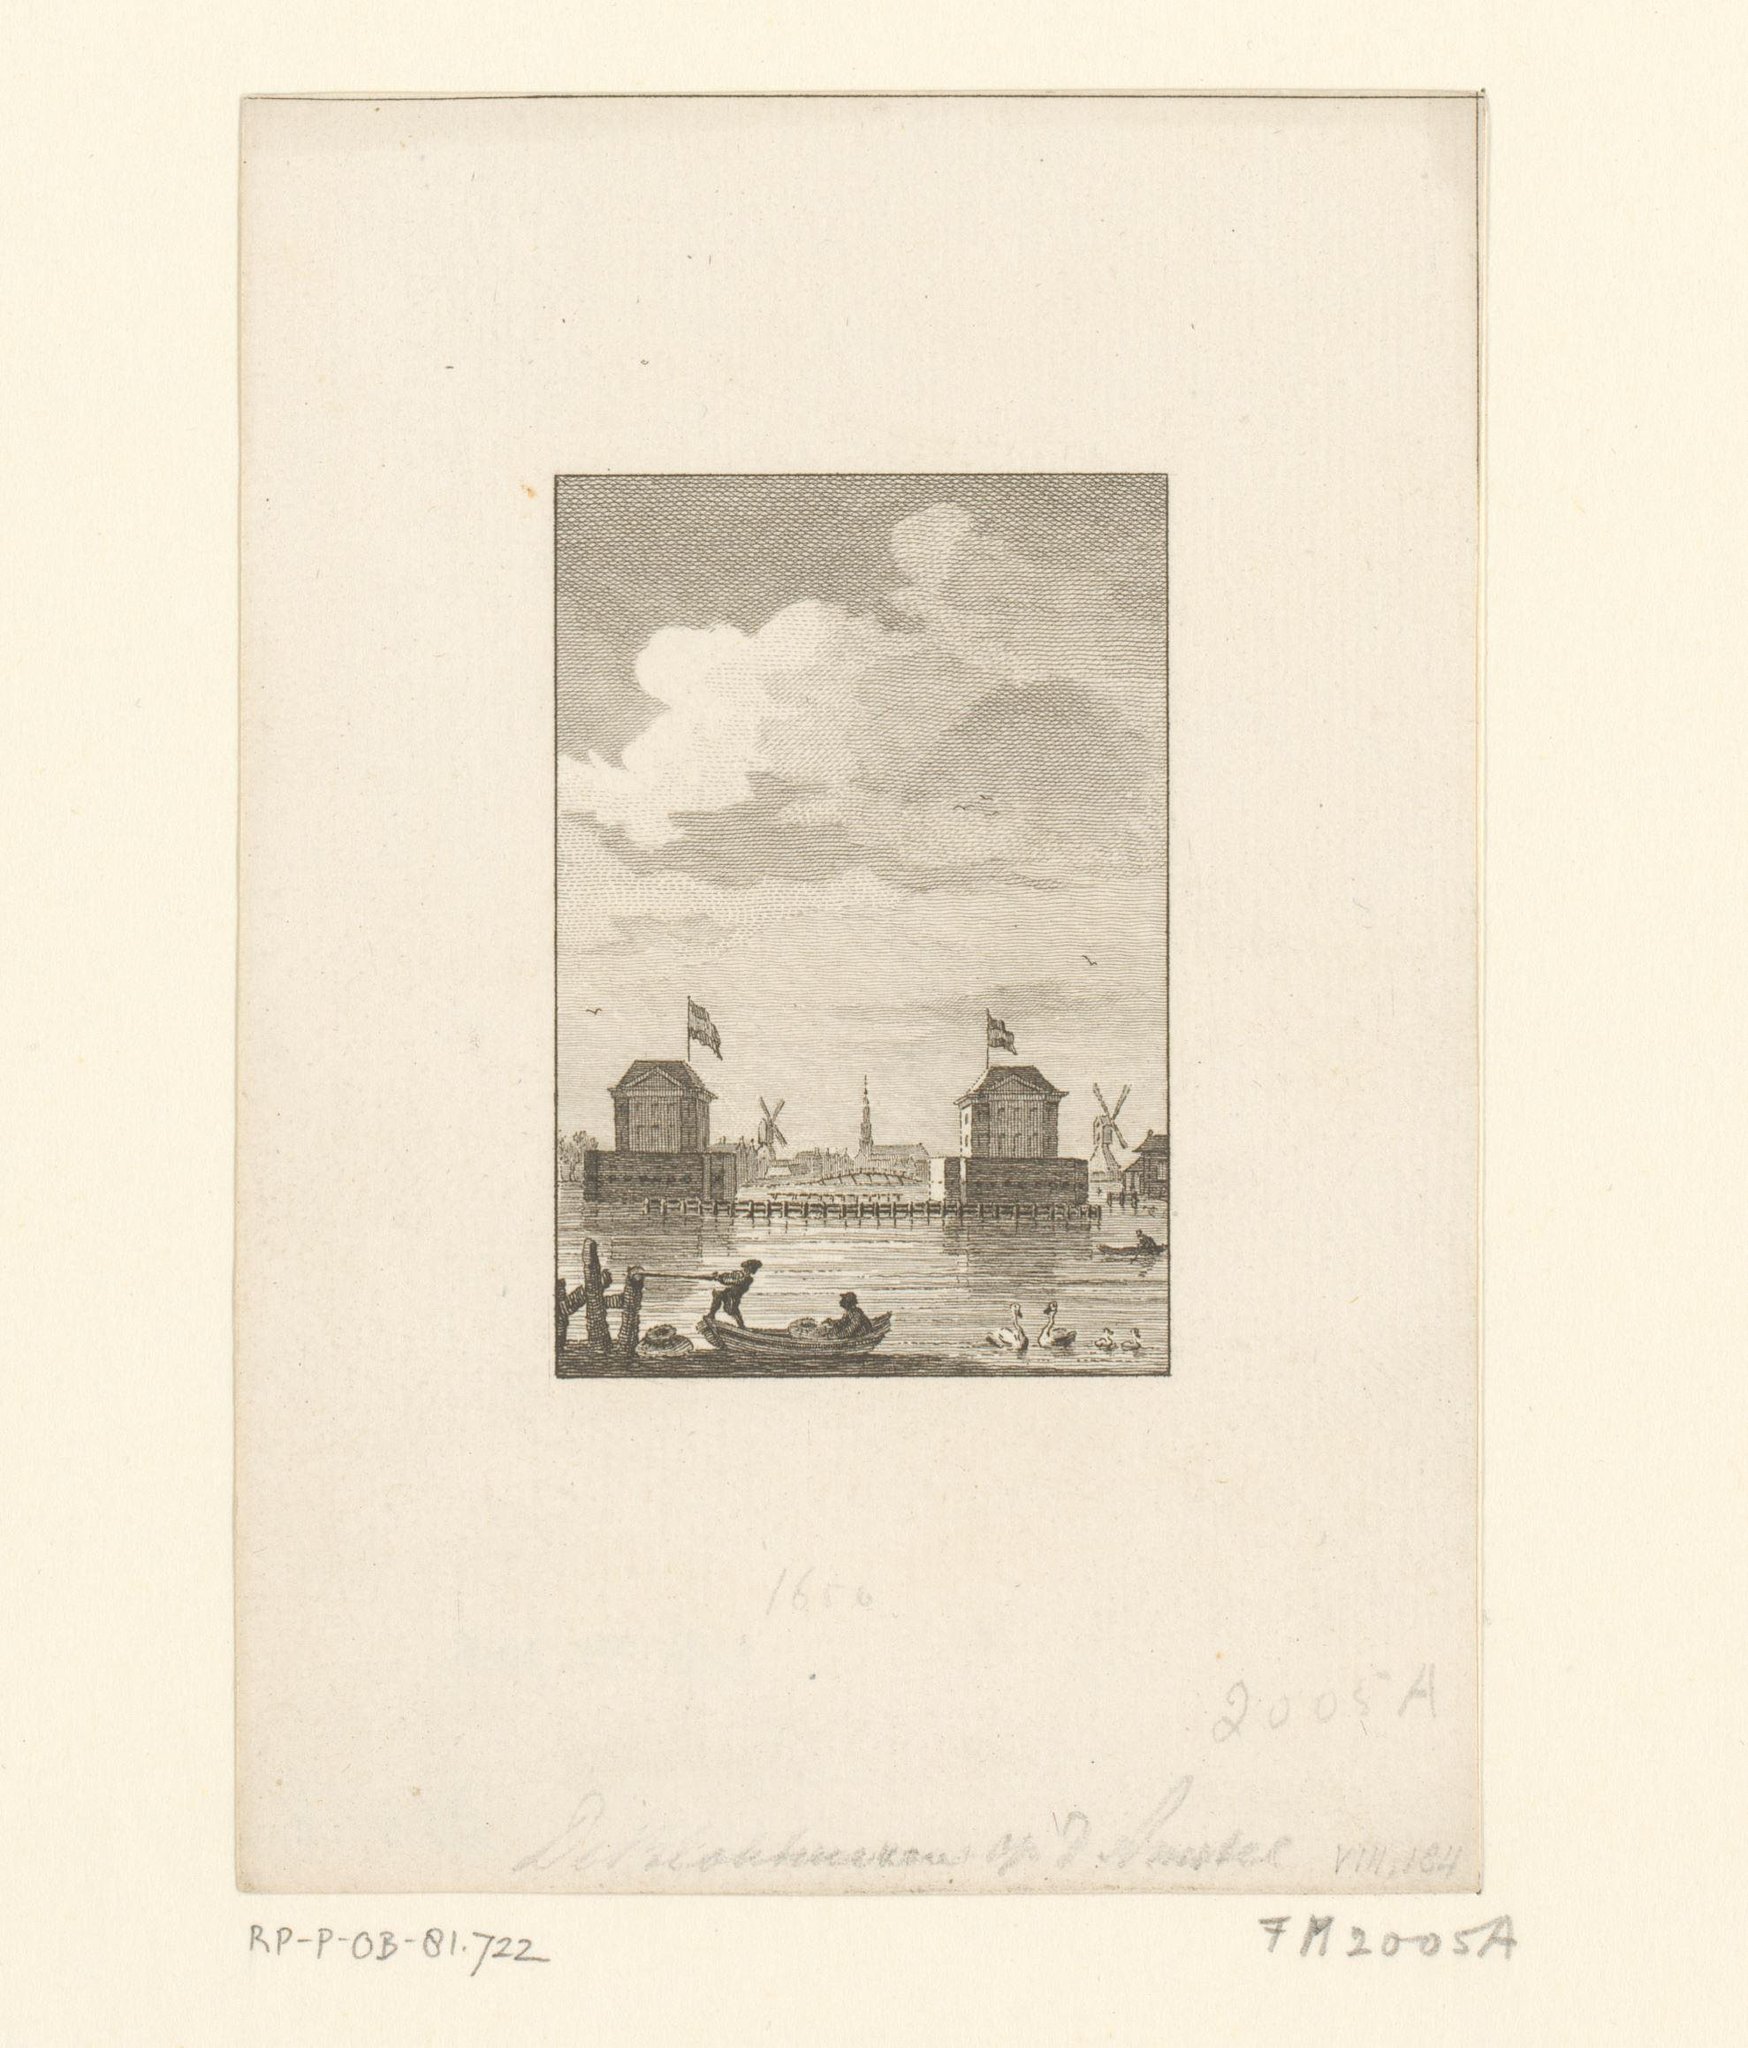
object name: print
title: Gezicht op de twee Blokhuizen in de Amstel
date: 1780-1795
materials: paper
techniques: etching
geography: northern netherlands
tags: fortress, amsterdam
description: Gebruikt als illustratie in: J. Fokke, Geschiedenissen der Vereenigde Nederlanden voor de vaderlandsche jeugd, Johannes Allart, Amsterdam 1783-1795, 25 delen, dl. VIII, pl. III. Dit nummer is een door het RPK toegevoegd nummer en staat niet in Frederik Muller, het werk waar de prent voor is gemaakt of uit afkomstig is, staat wel vermeld in Frederik Muller.